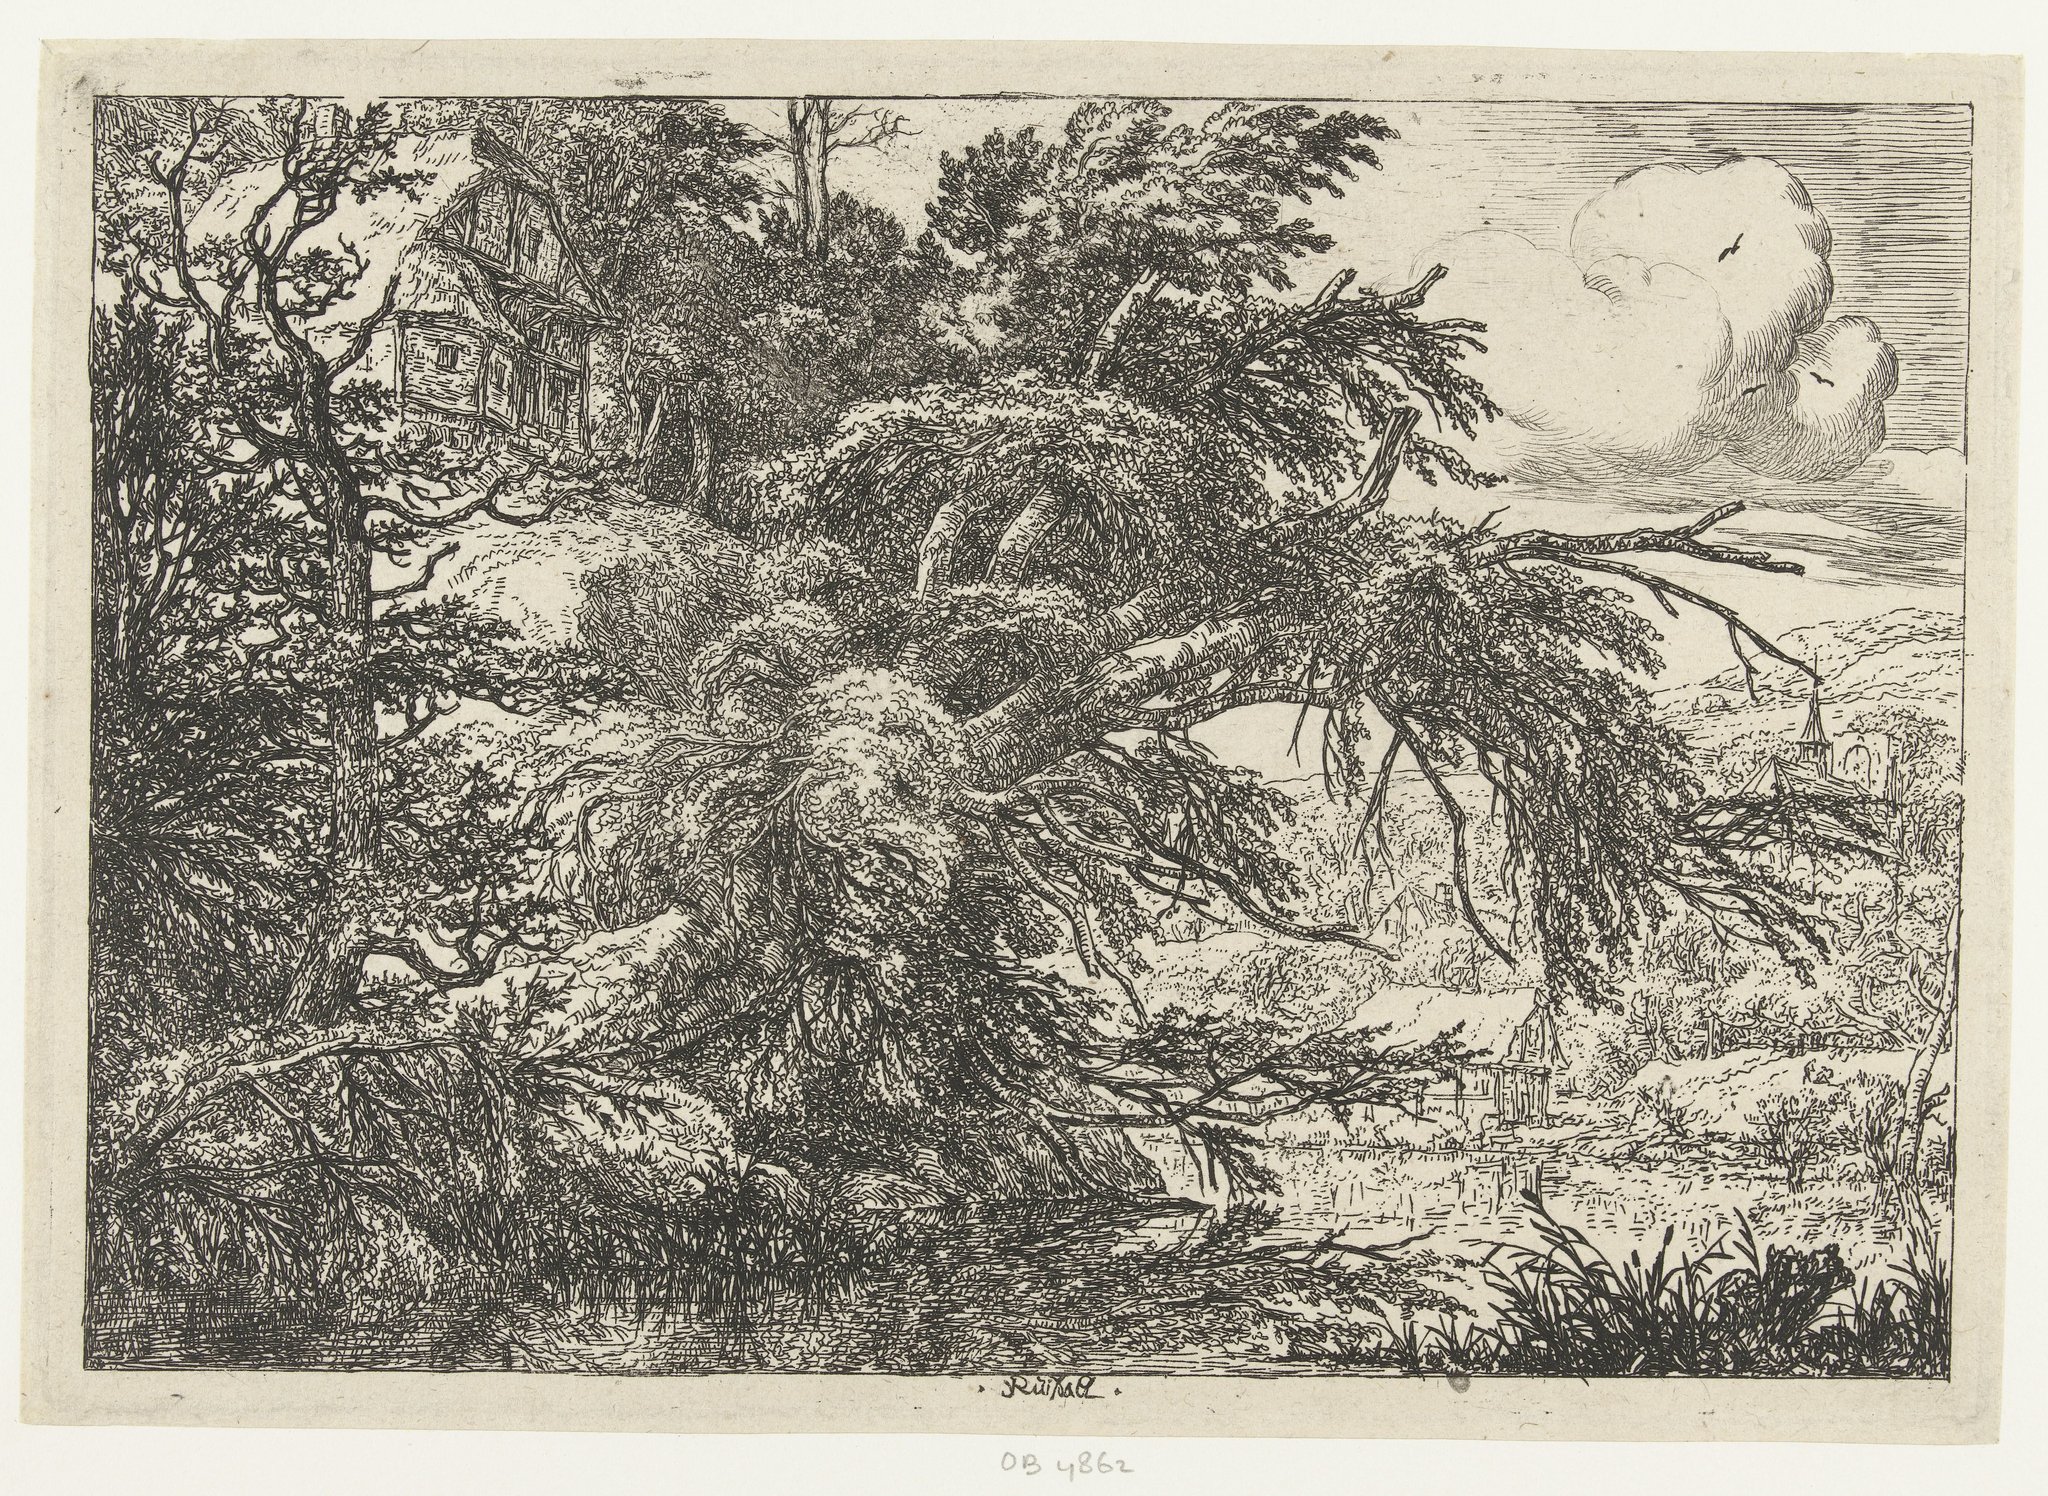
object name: print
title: Boerderij op een heuvel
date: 1650-1699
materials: paper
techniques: etching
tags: farm or solitary house in landscape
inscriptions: collector's mark: Lugt 240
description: Volgens Slive (2001) zijn de wolken in de tweede staat mogelijk toegevoegd vóór het einde van de 17e eeuw, zie p. 605.